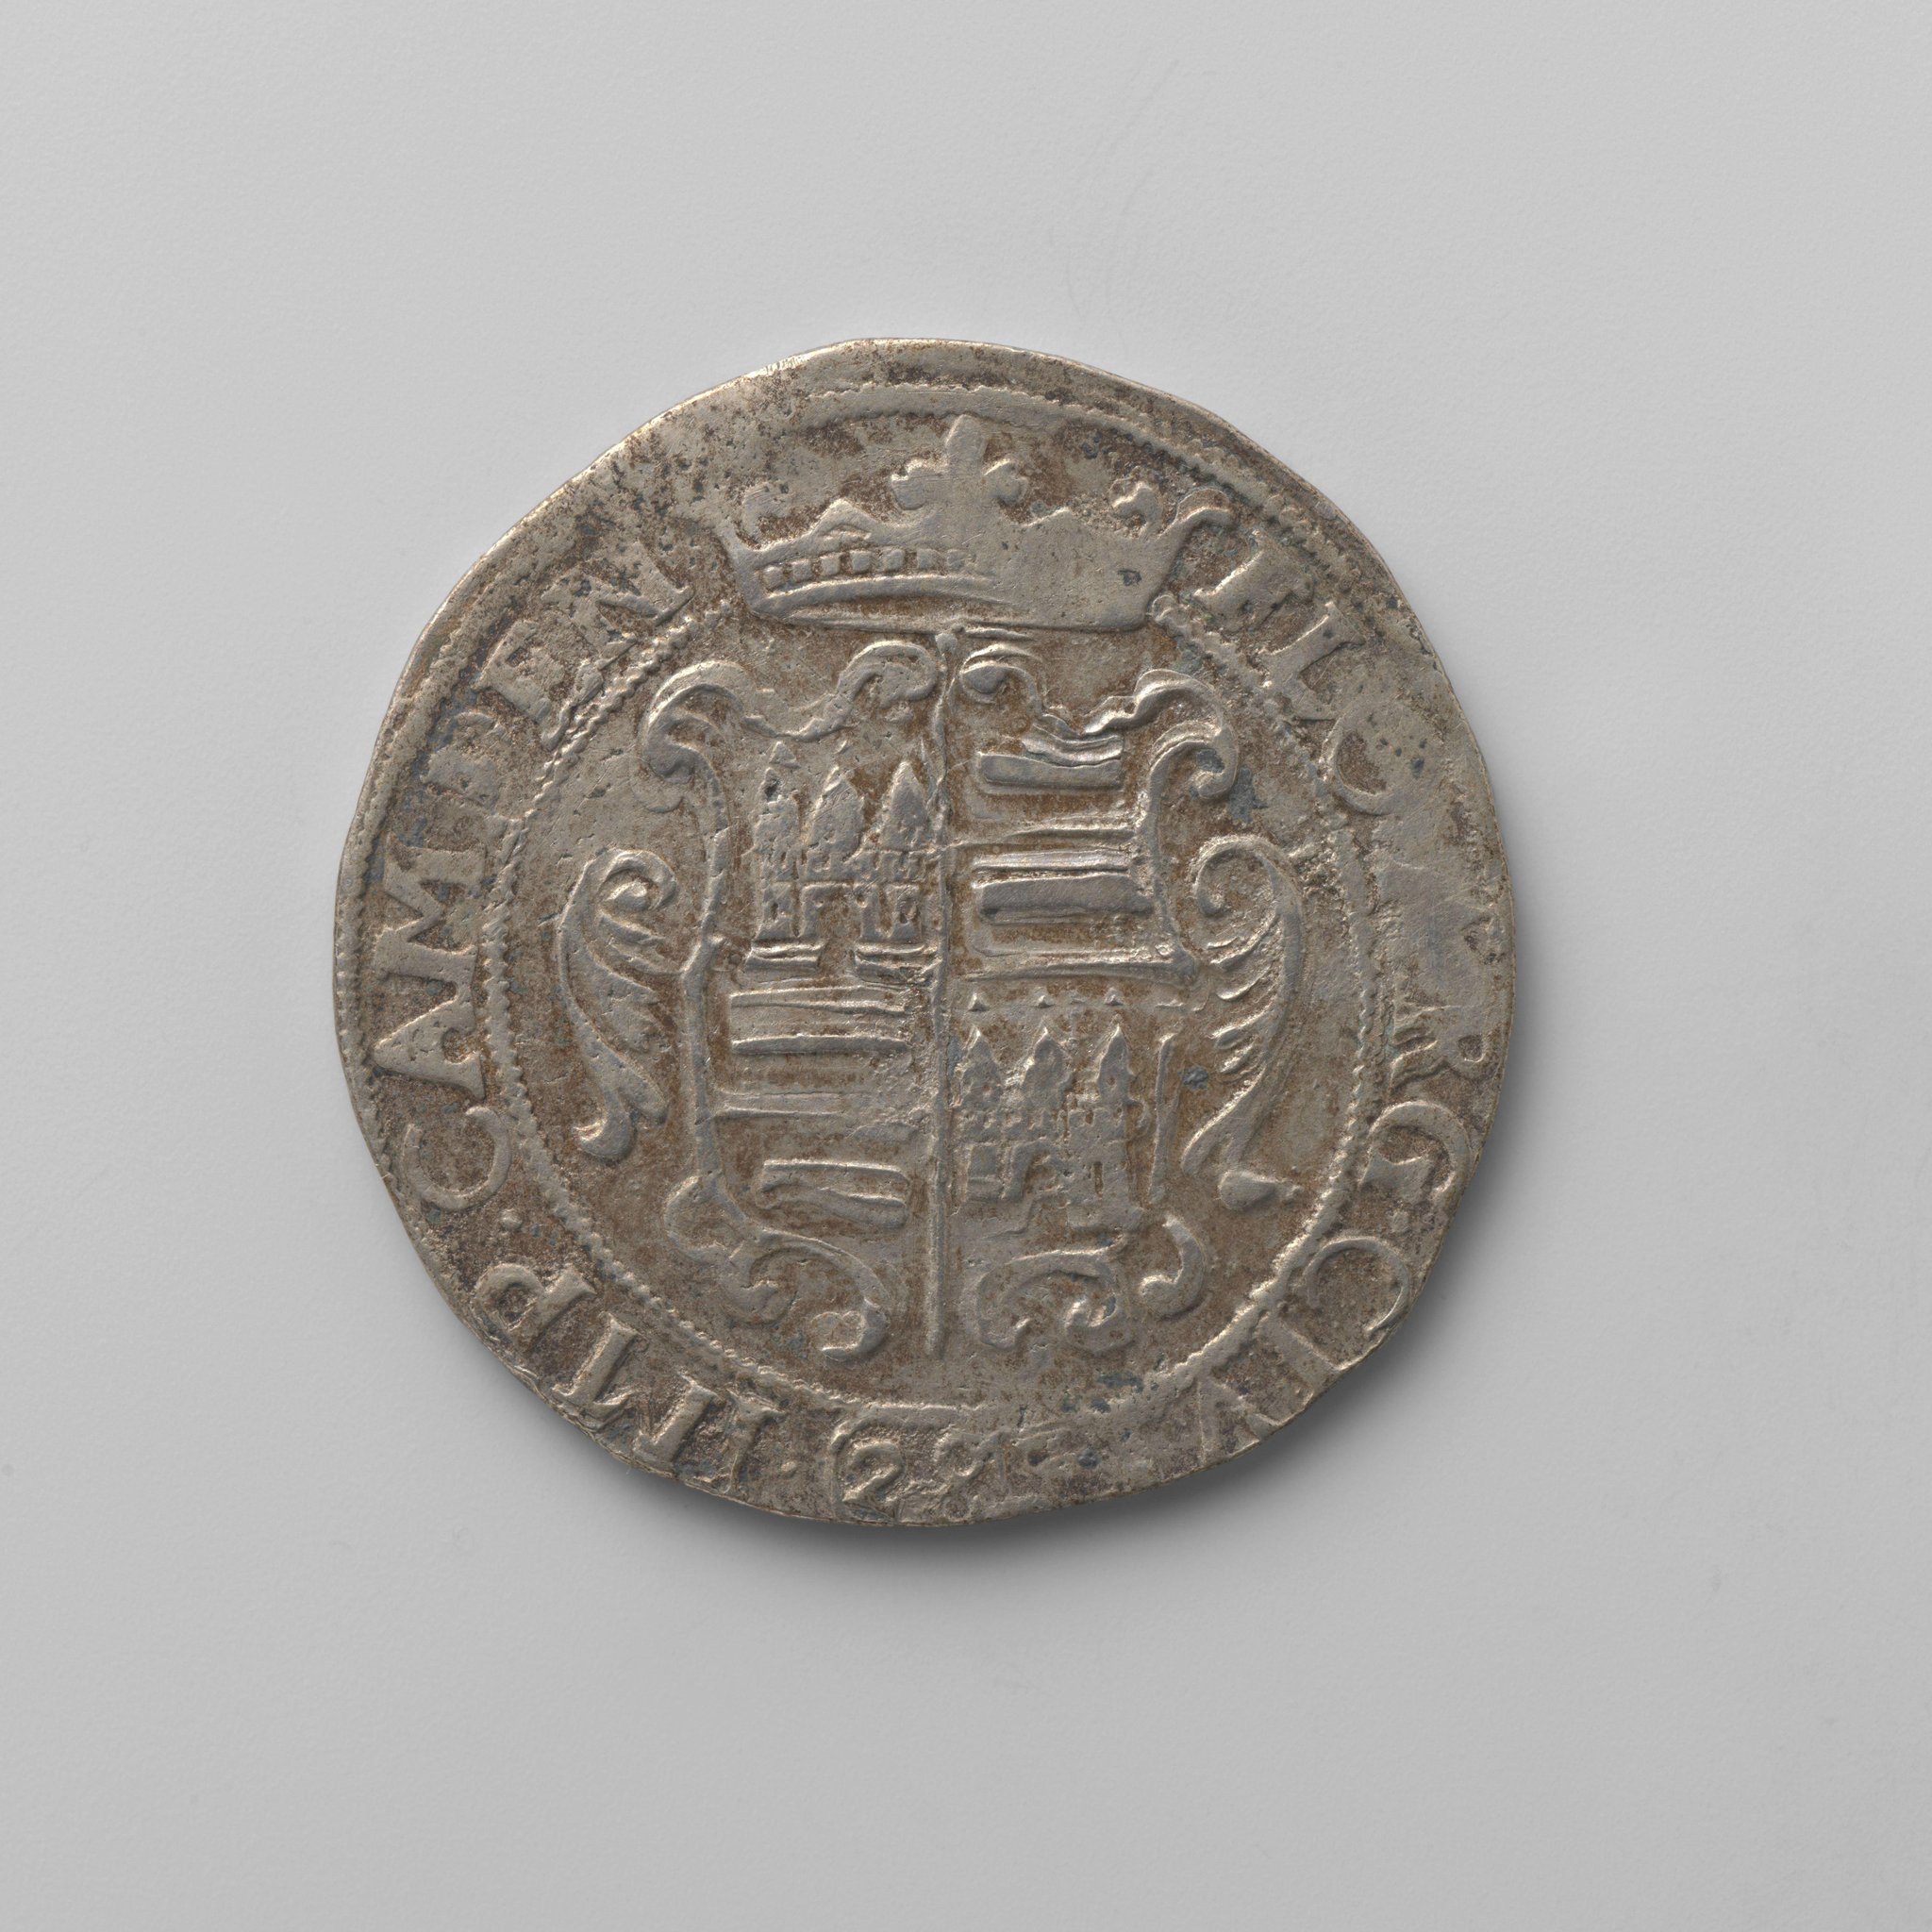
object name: coin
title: Kampen, florijn, 1618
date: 1618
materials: silver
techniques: striking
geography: kampen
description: Zilveren munt. Voorzijde: versierd en gekroond gevierendeeld wapenschild. Jaartal boven kroon. Keerzijde: gekroonde dubbelkoppige adelaar met op de borst rijksappel, waarin waarde-aanduiding 28.